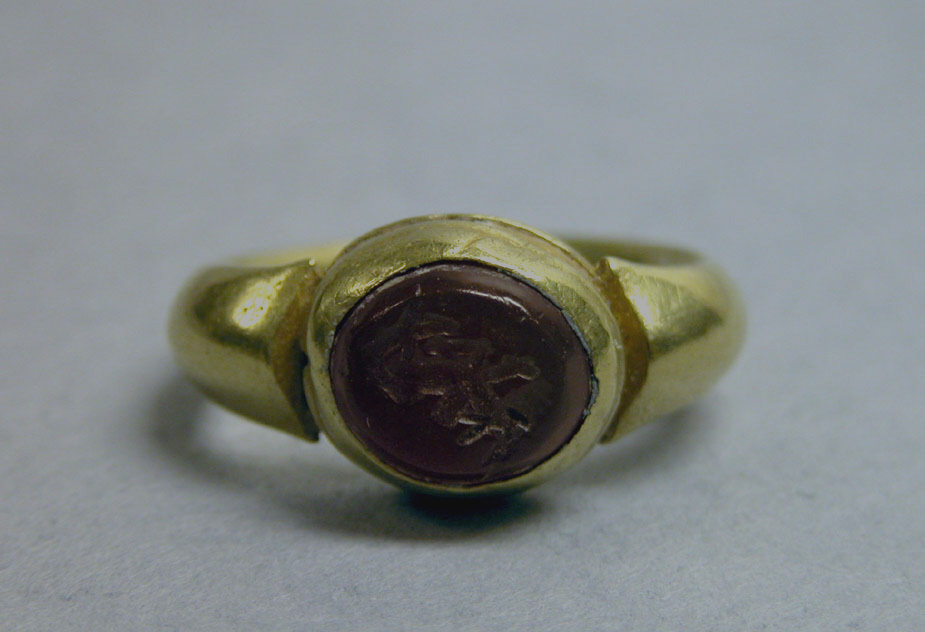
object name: ring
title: Ring with Inset Oval-Shaped Stone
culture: indonesian, javanese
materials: gold, stone